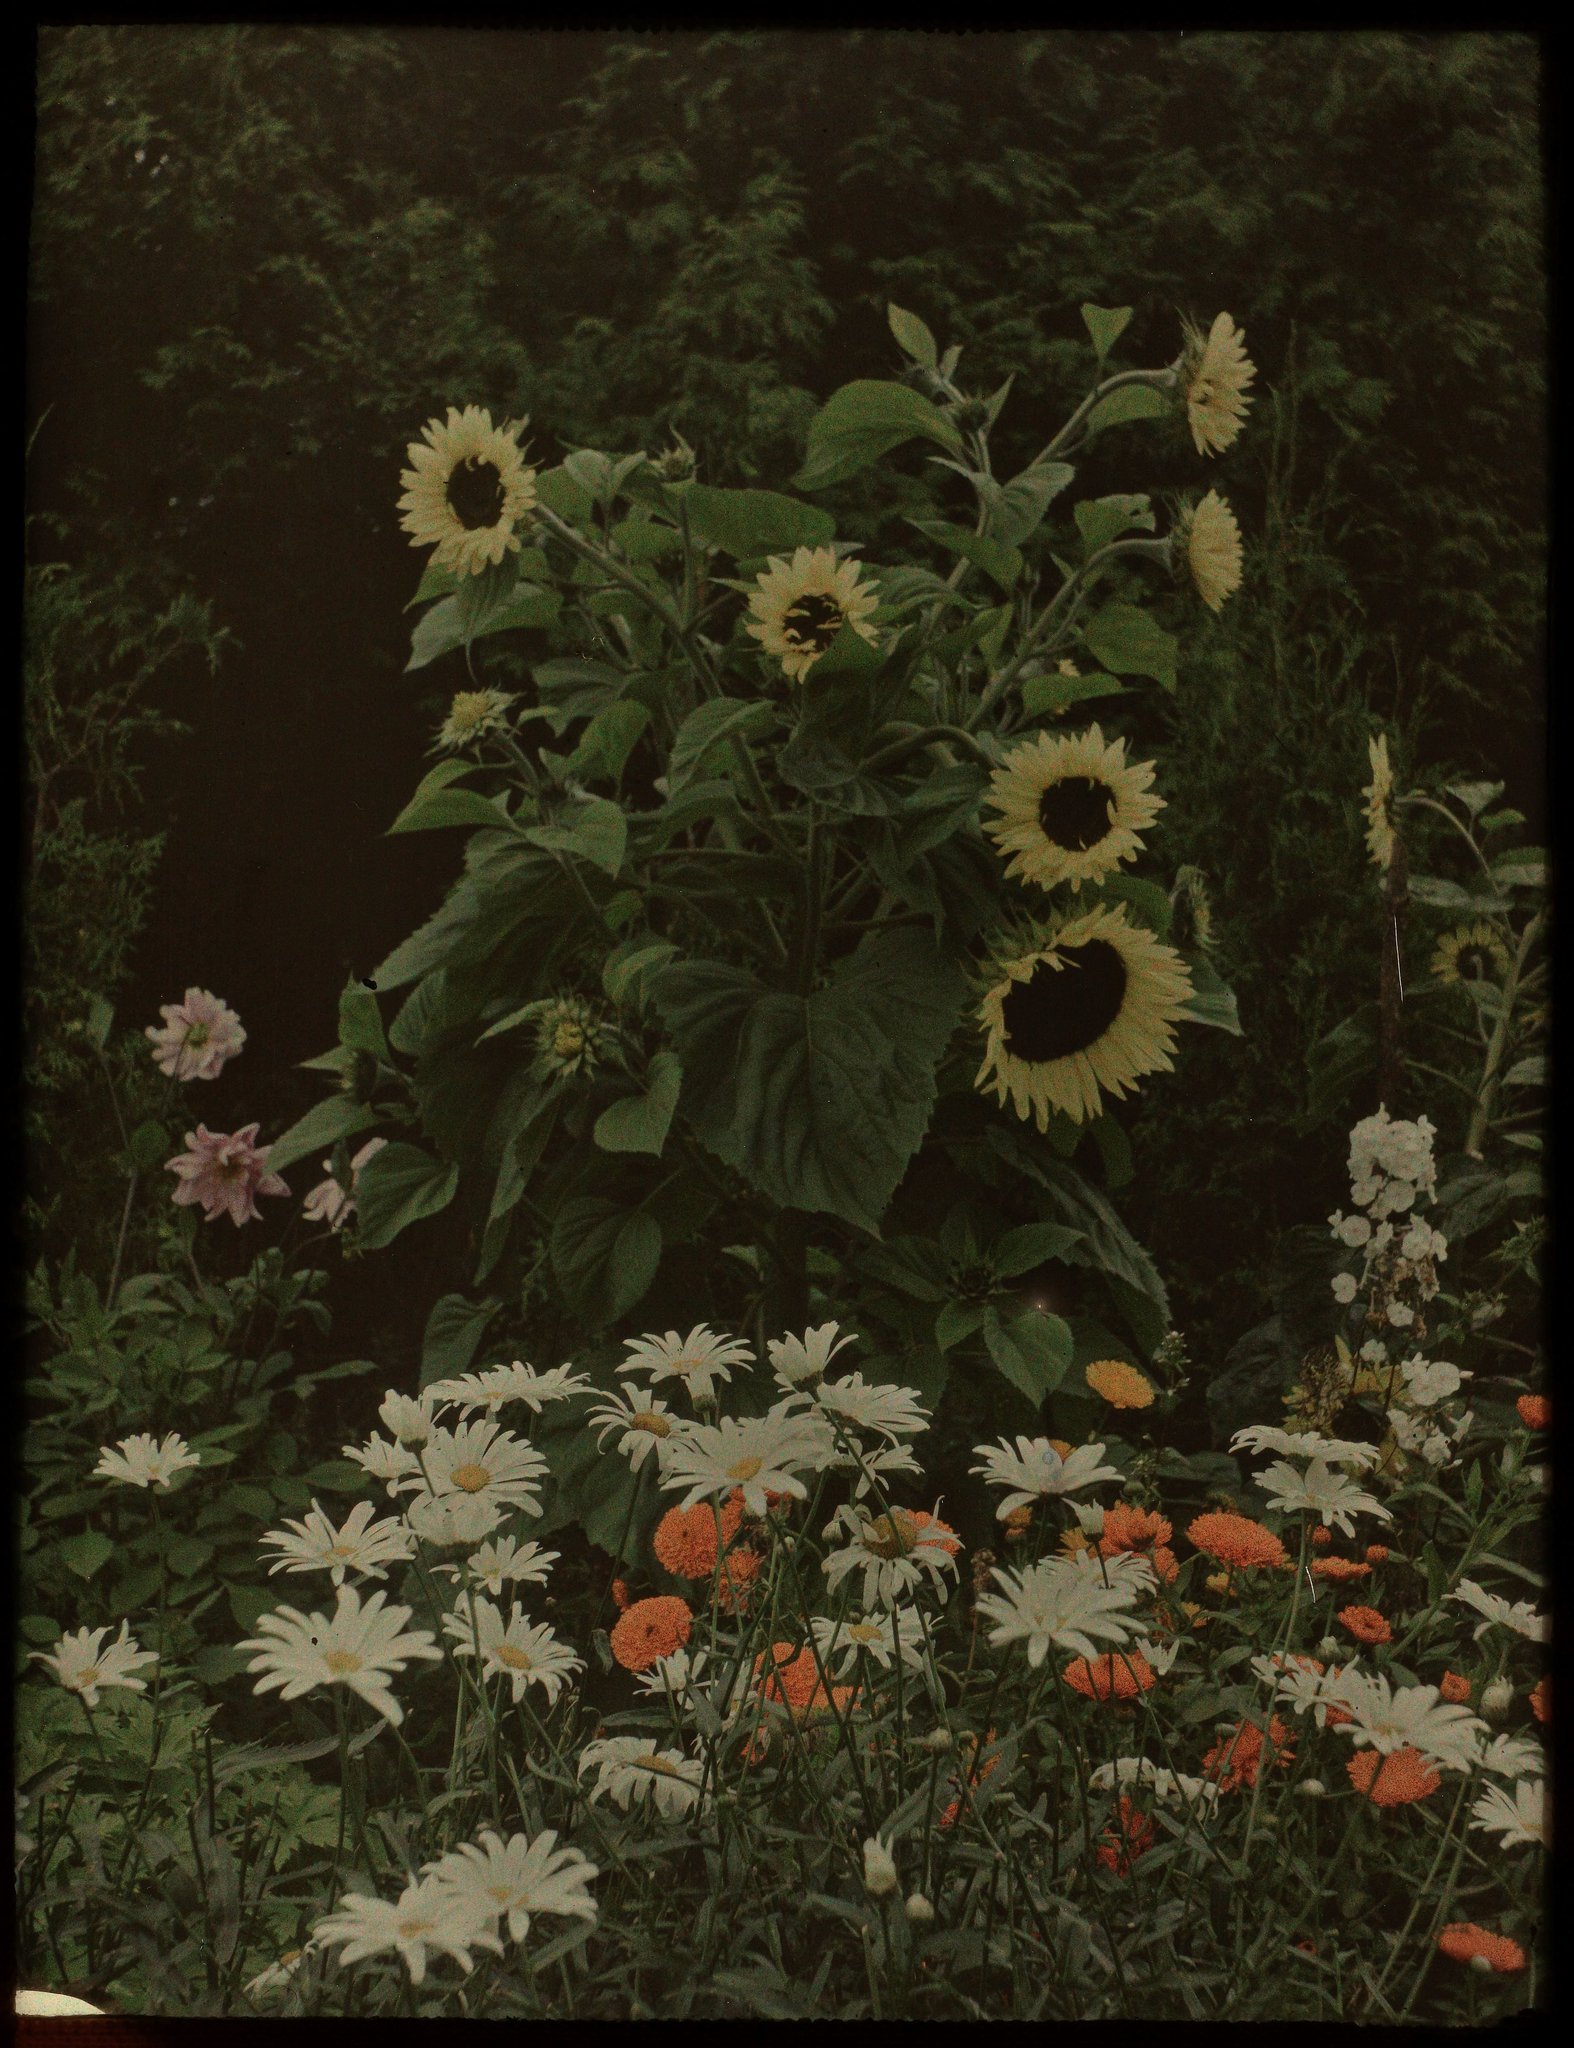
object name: photograph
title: Tuin van het huis Kersbergen, Zeist, met onder andere zonnebloemen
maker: lambertus hendrik van berk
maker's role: fotograaf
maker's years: 1869-1950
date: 1914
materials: glass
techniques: autochrome process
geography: zeist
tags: flowers, flower-bed, zeist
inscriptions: label: ‘…10’